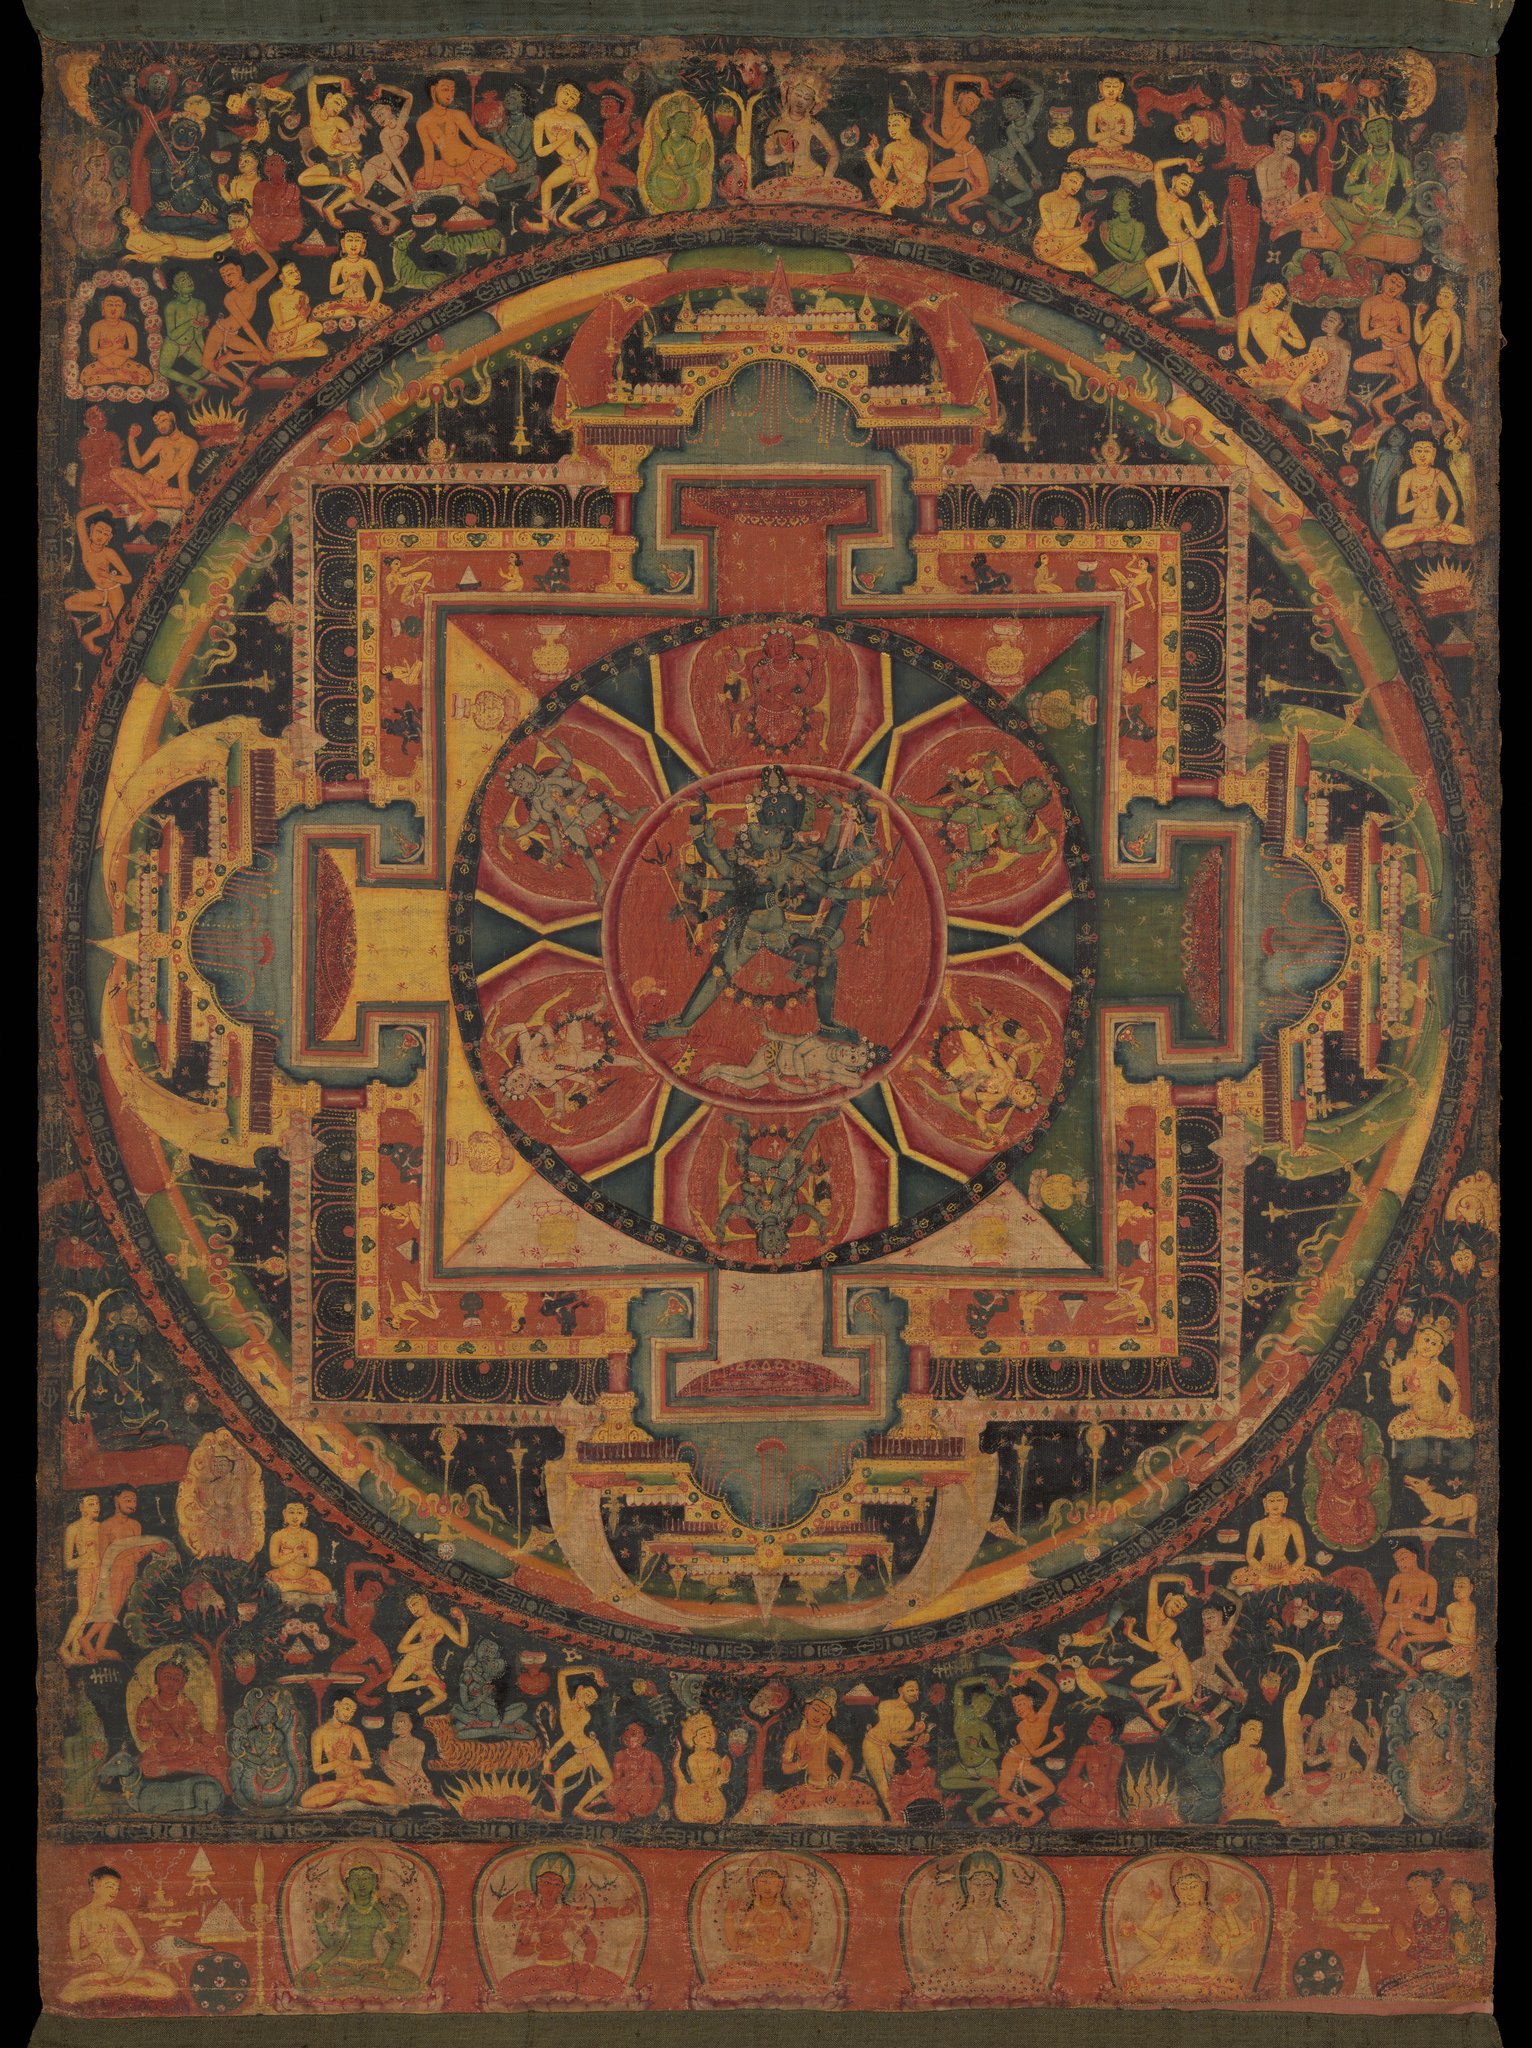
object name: thangka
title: Chakrasamvara Mandala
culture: nepali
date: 1100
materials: textile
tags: deities,goddess